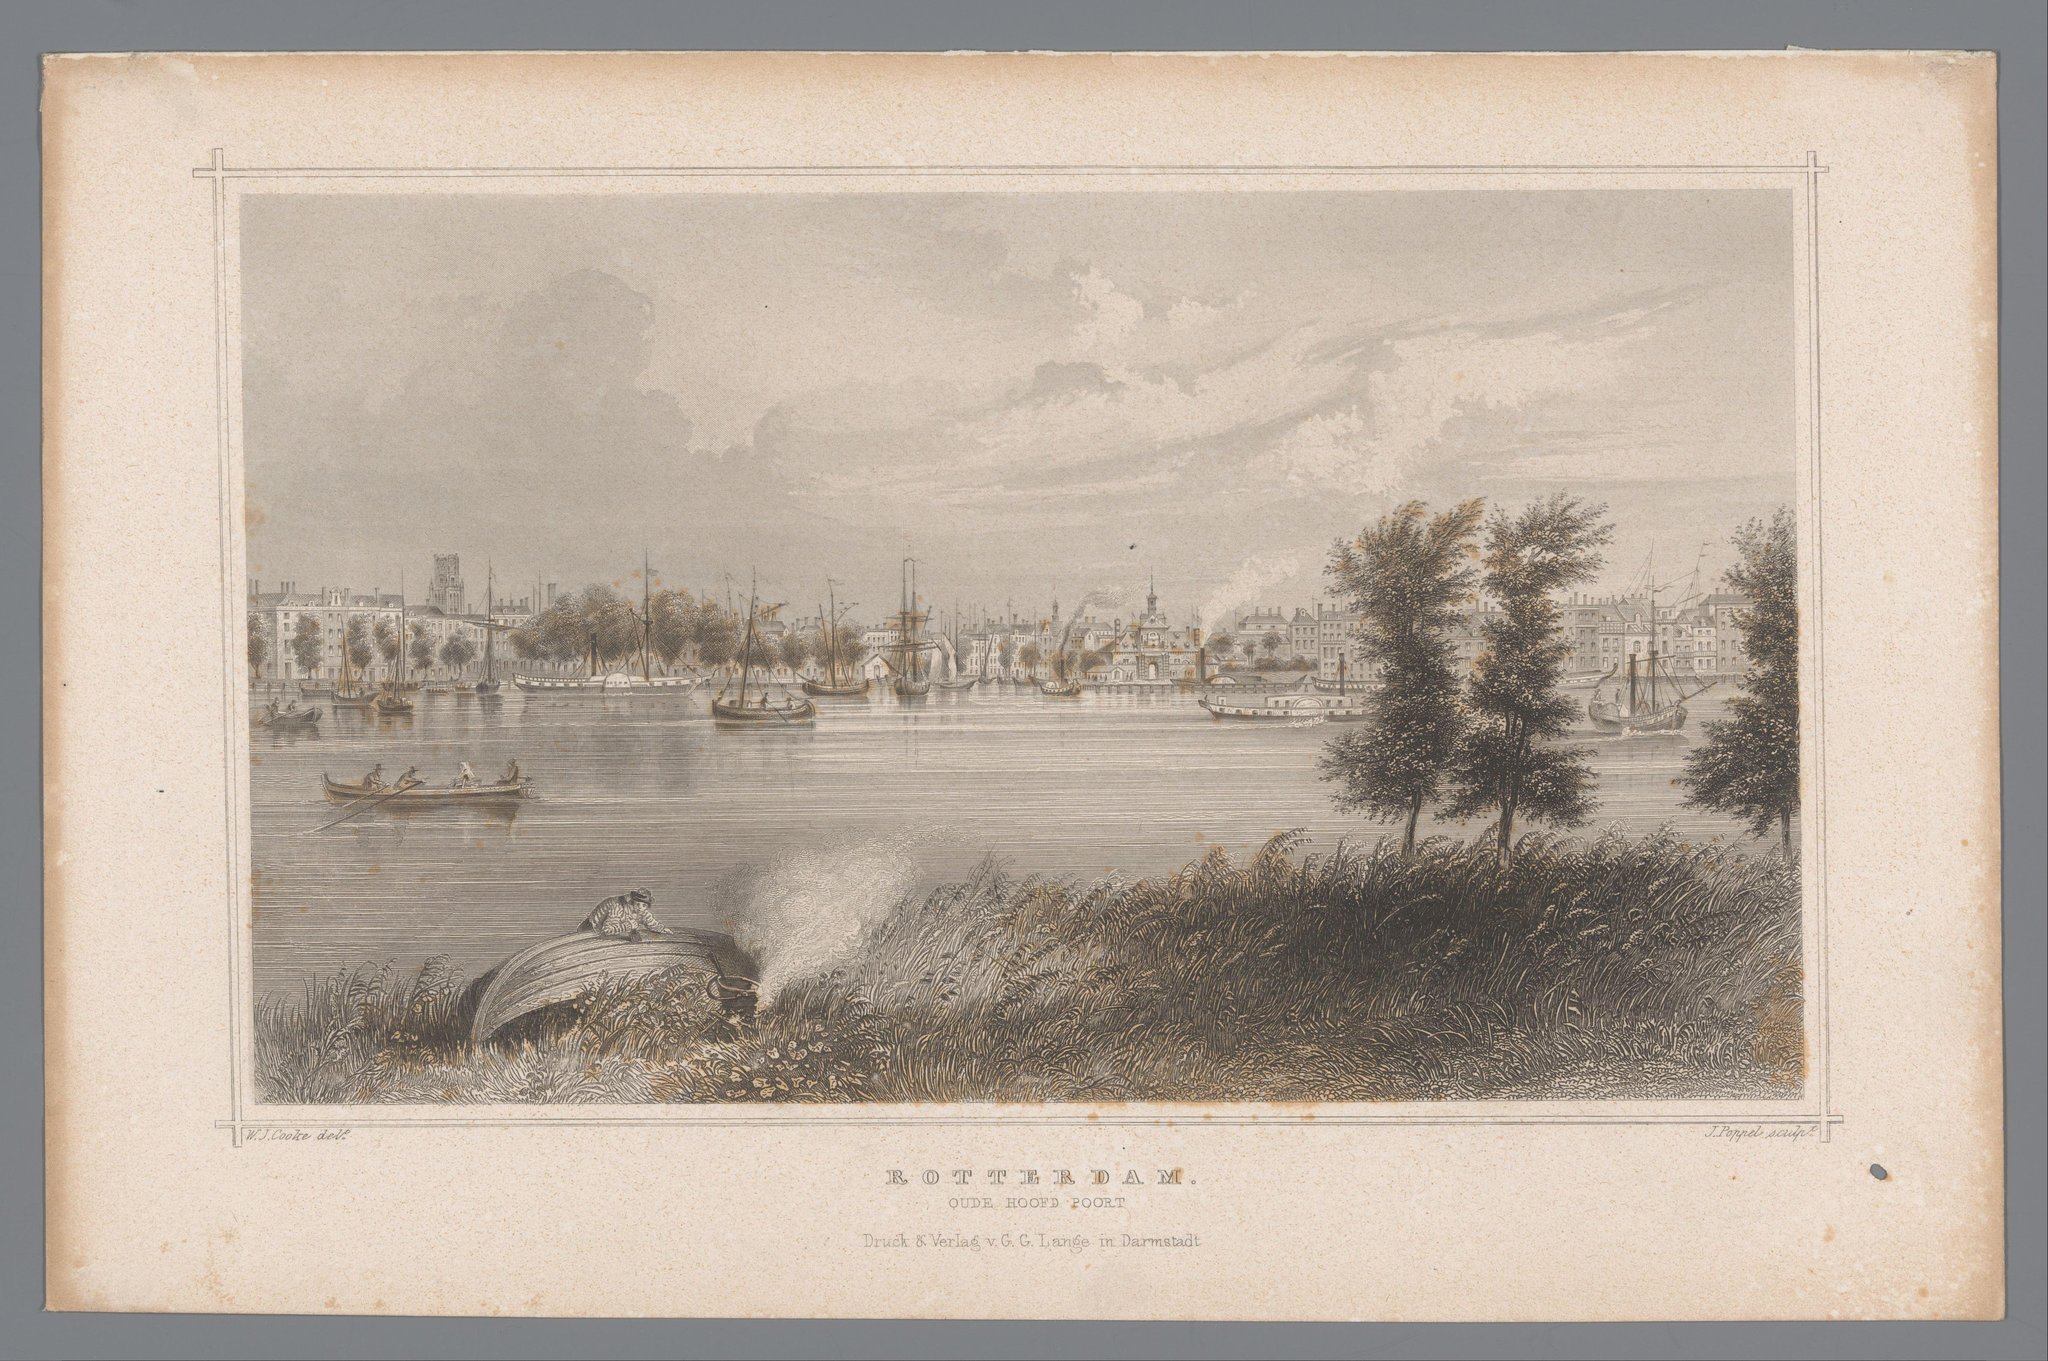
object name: book illustration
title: Gezicht op de Ooster Oude Hoofdpoort in Rotterdam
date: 1863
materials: paper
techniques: engraving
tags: sailing-ship, sailing-boat, city-view in general; 'veduta', rowing-boat, canoe, etc., rotterdam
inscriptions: collector's mark: Lugt 2233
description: Prent uit: Der Rhein und die Rheinlande in malerischen Original-ansichten. 3 dln. Darmstadt: G.G. Lange, 1863, dl. 3, p. 138-139. Dezelfde prent, met een ander onderschrift, komt ook voor in: Terwen, J.L. Het koningrijk der Nederlanden (...). 2 dln. Gouda: G.B. van Goor, 1857, p. 252-253.